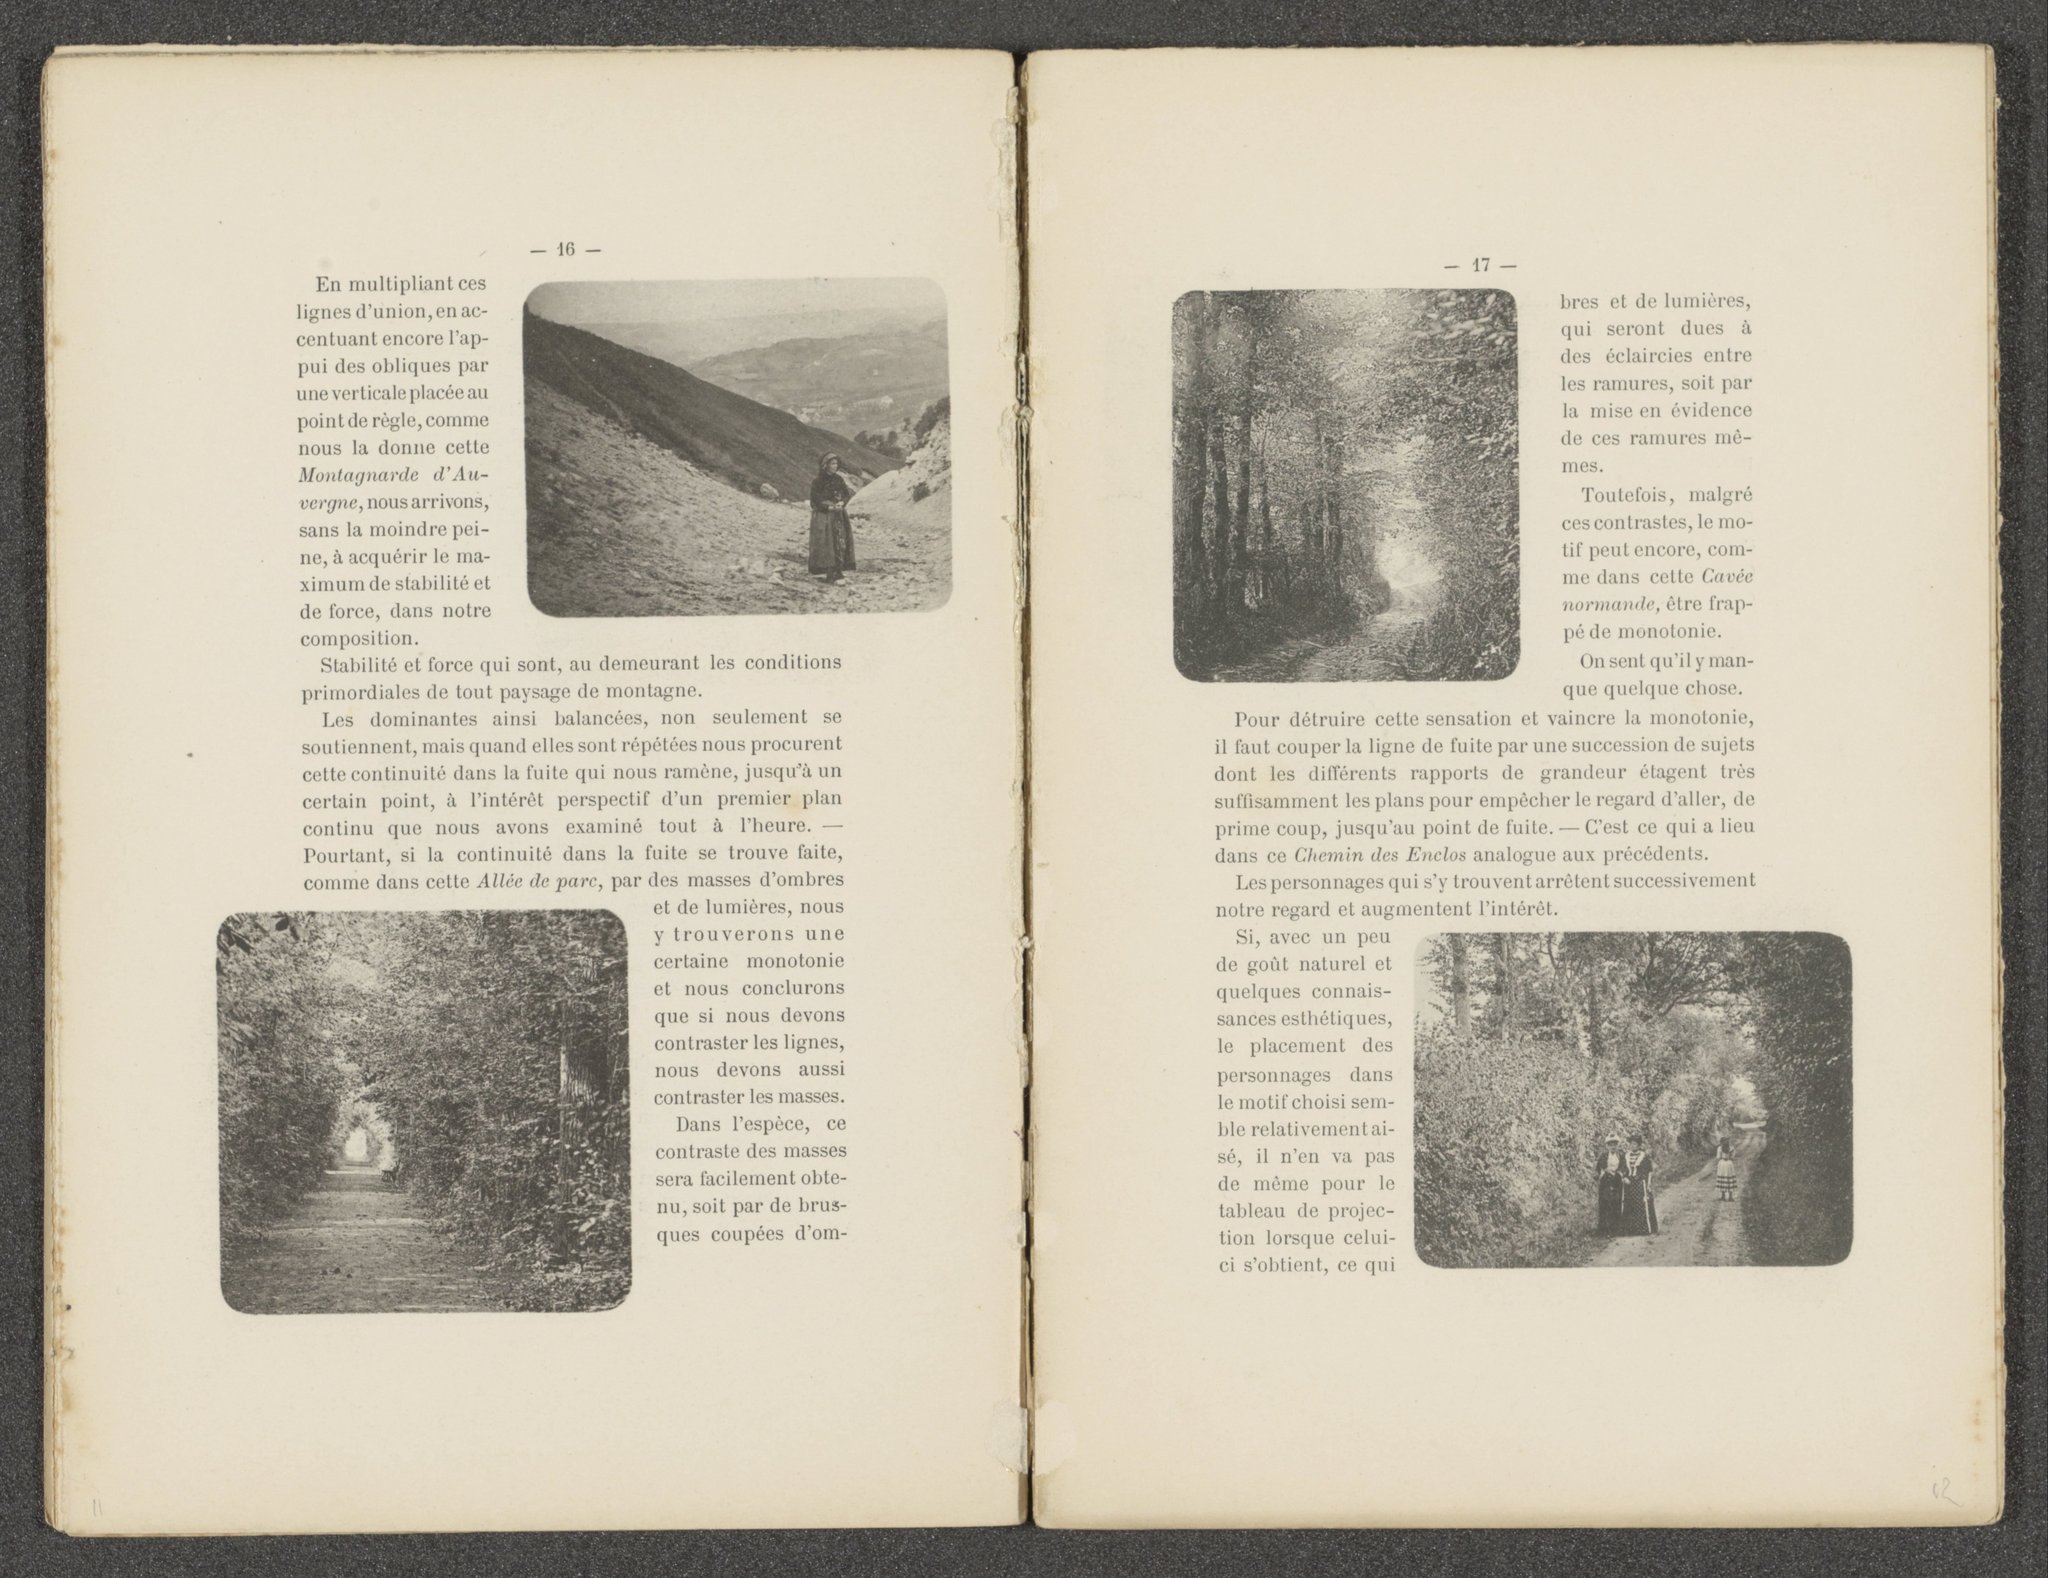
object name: page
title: Vrouw op een berg en een bospad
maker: Anonymous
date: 1886-1896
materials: paper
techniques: photograph, printing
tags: adult woman, forest path or lane, mountains